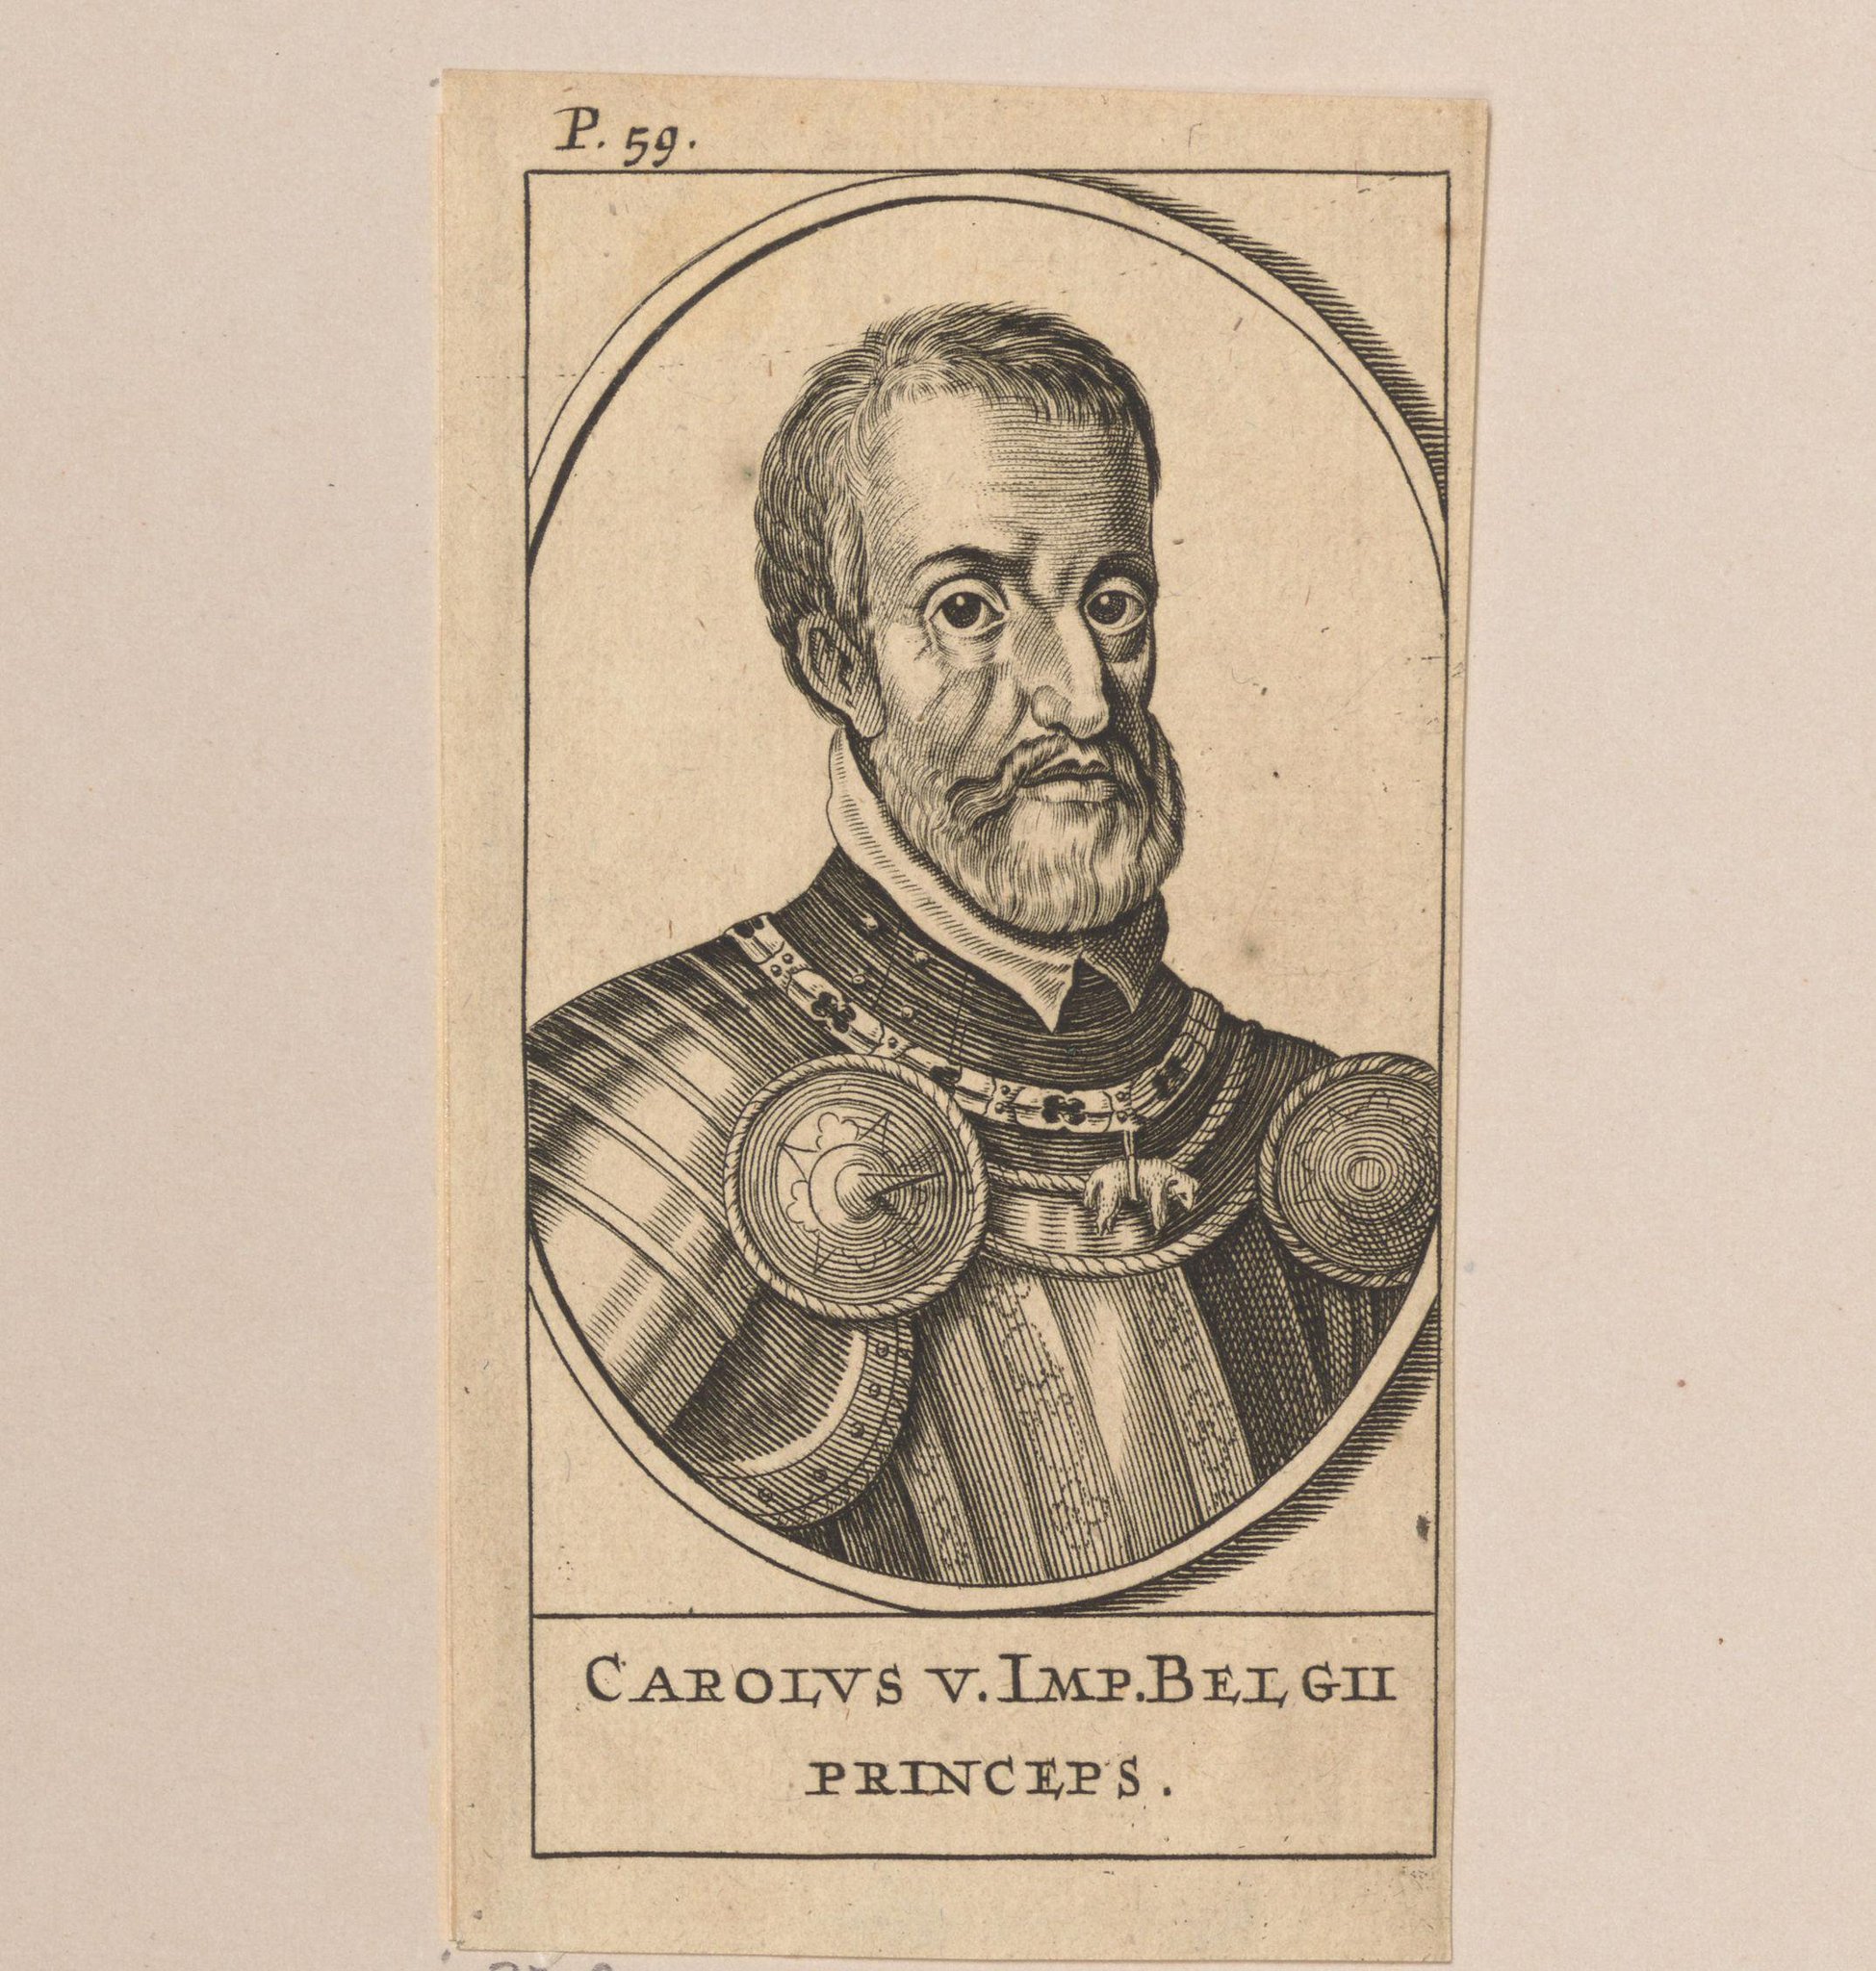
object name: print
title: Portret van keizer Karel V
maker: Anonymous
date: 1653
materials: paper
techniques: engraving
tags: ghent, charles v (holy roman emperor and king of spain), harness, historical persons, knighthood order of the golden fleece, king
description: Prent mogelijk uit: Strada, Famiano. Famiani Stradæ Romani e Societate Jesu de bello Belgico (...). Rome: Hermann Scheus, 1653.